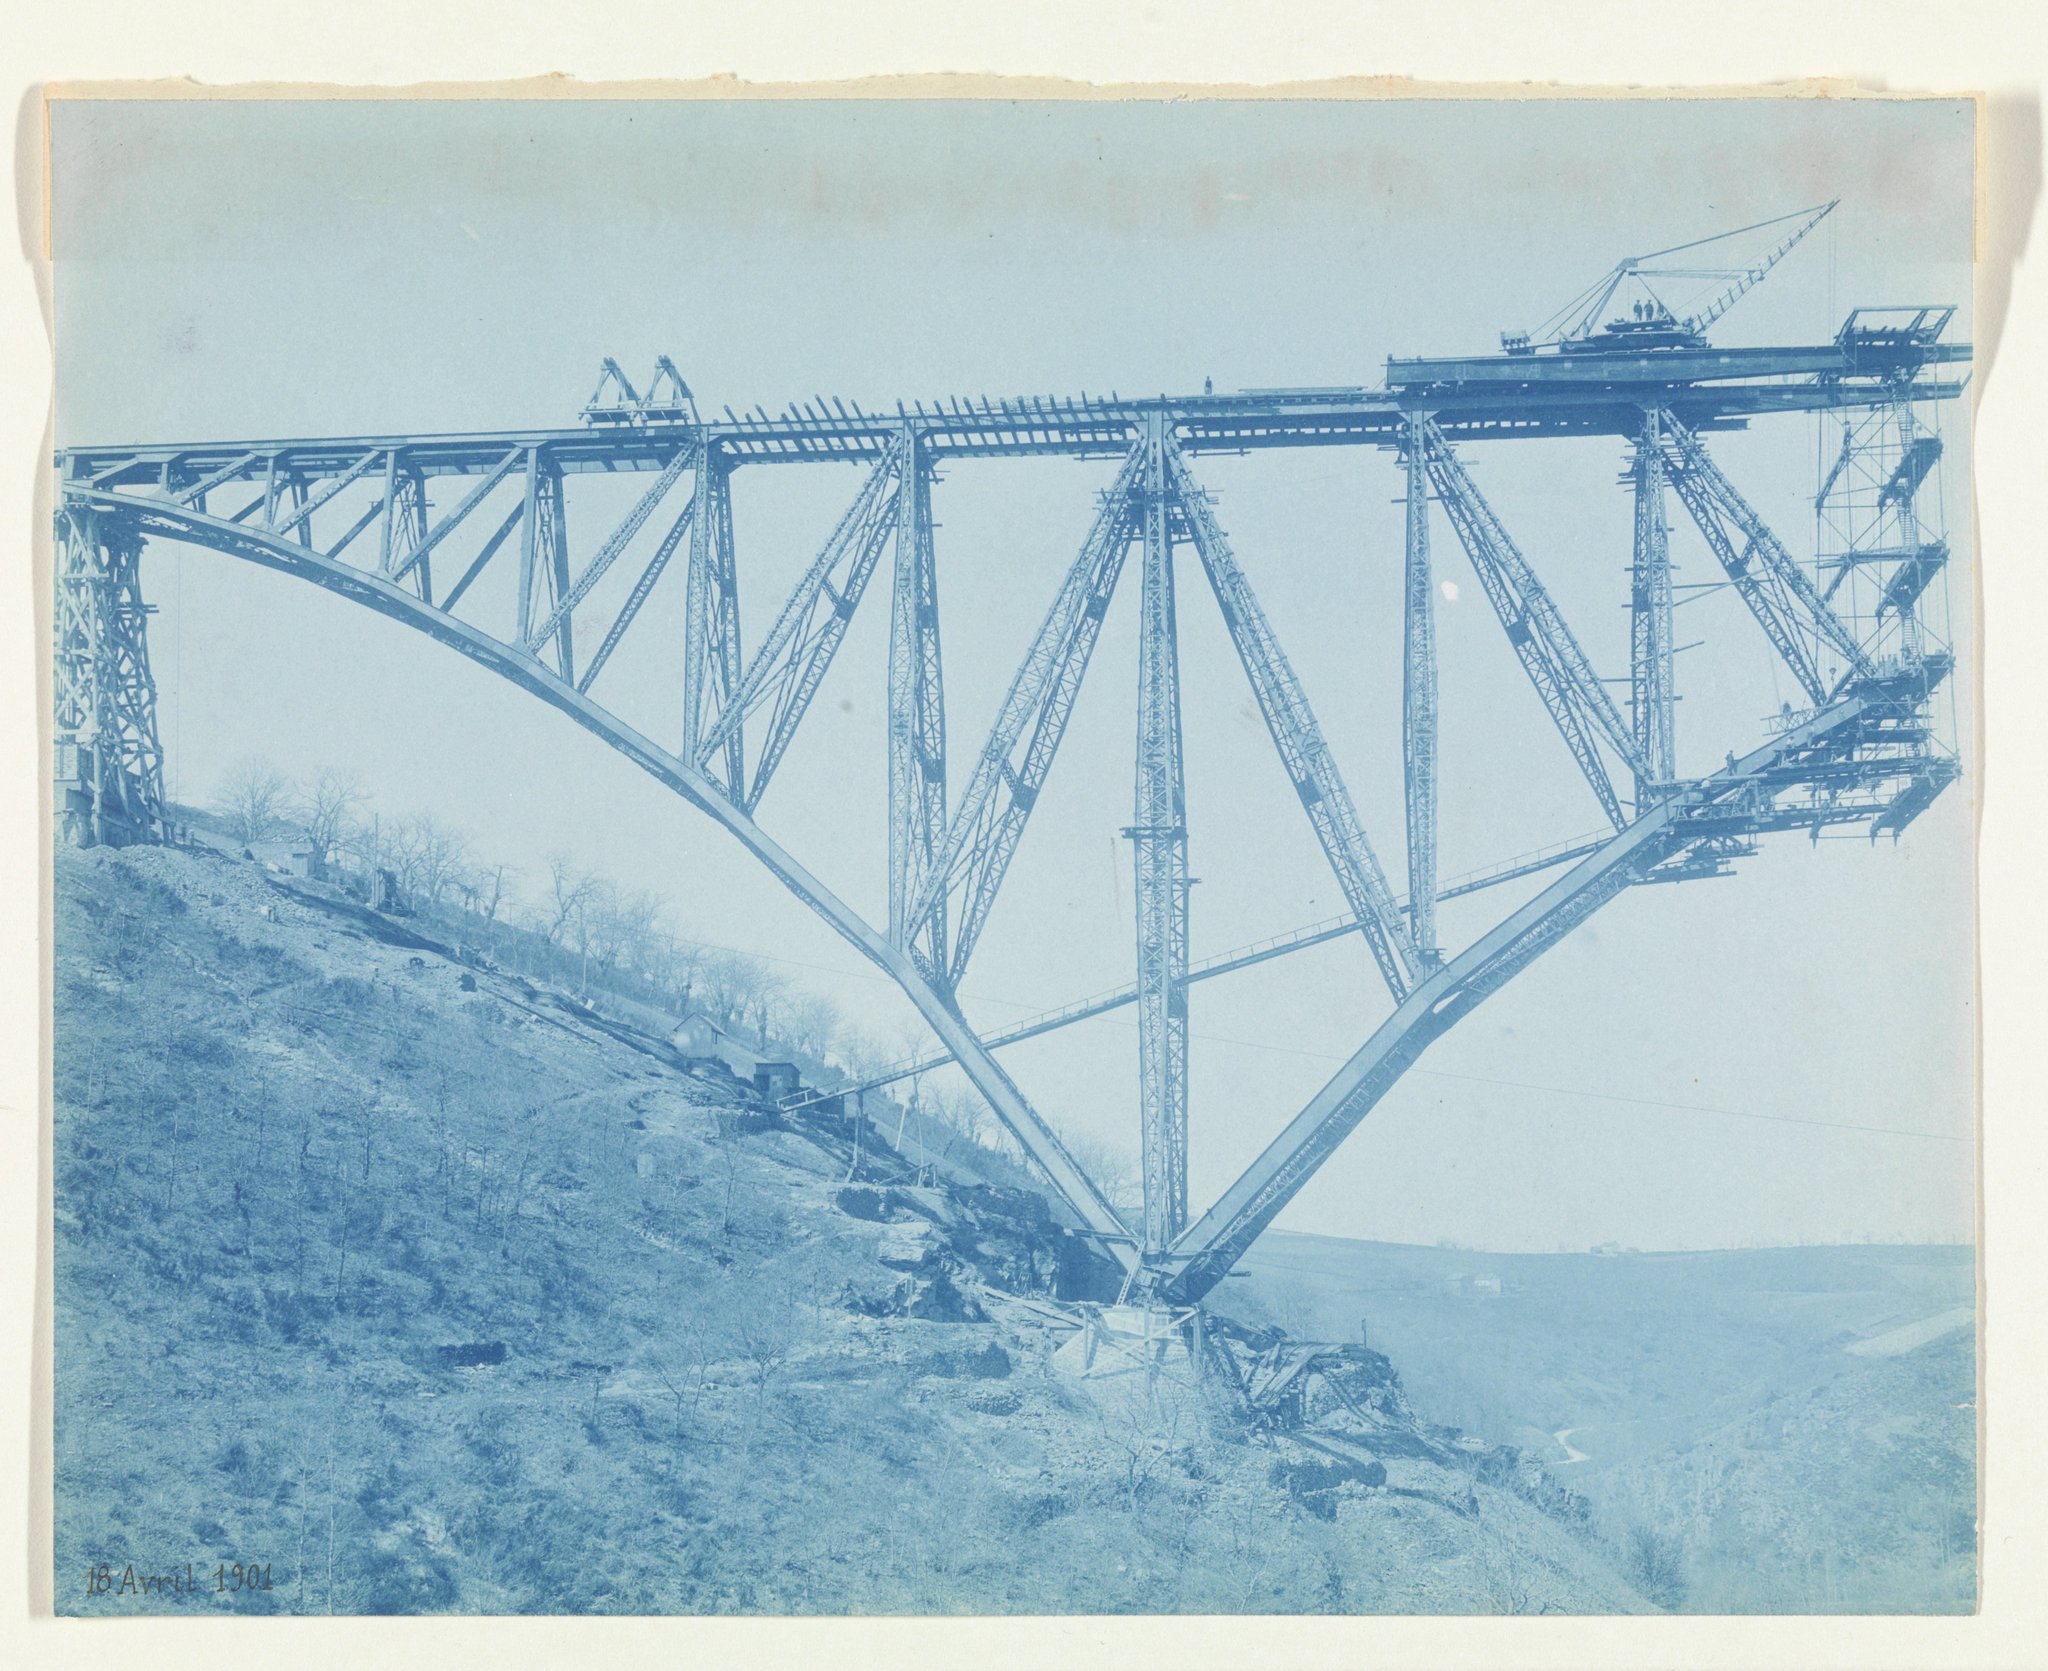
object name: photograph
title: Aanleg van het Viaur Viaduct in Frankrijk door de Societé de Construction des Battignolles, 18 april 1901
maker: Anonymous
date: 1901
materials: photographic support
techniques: cyanotype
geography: france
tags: viaduct, making the overground structures (~ building activities)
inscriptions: date